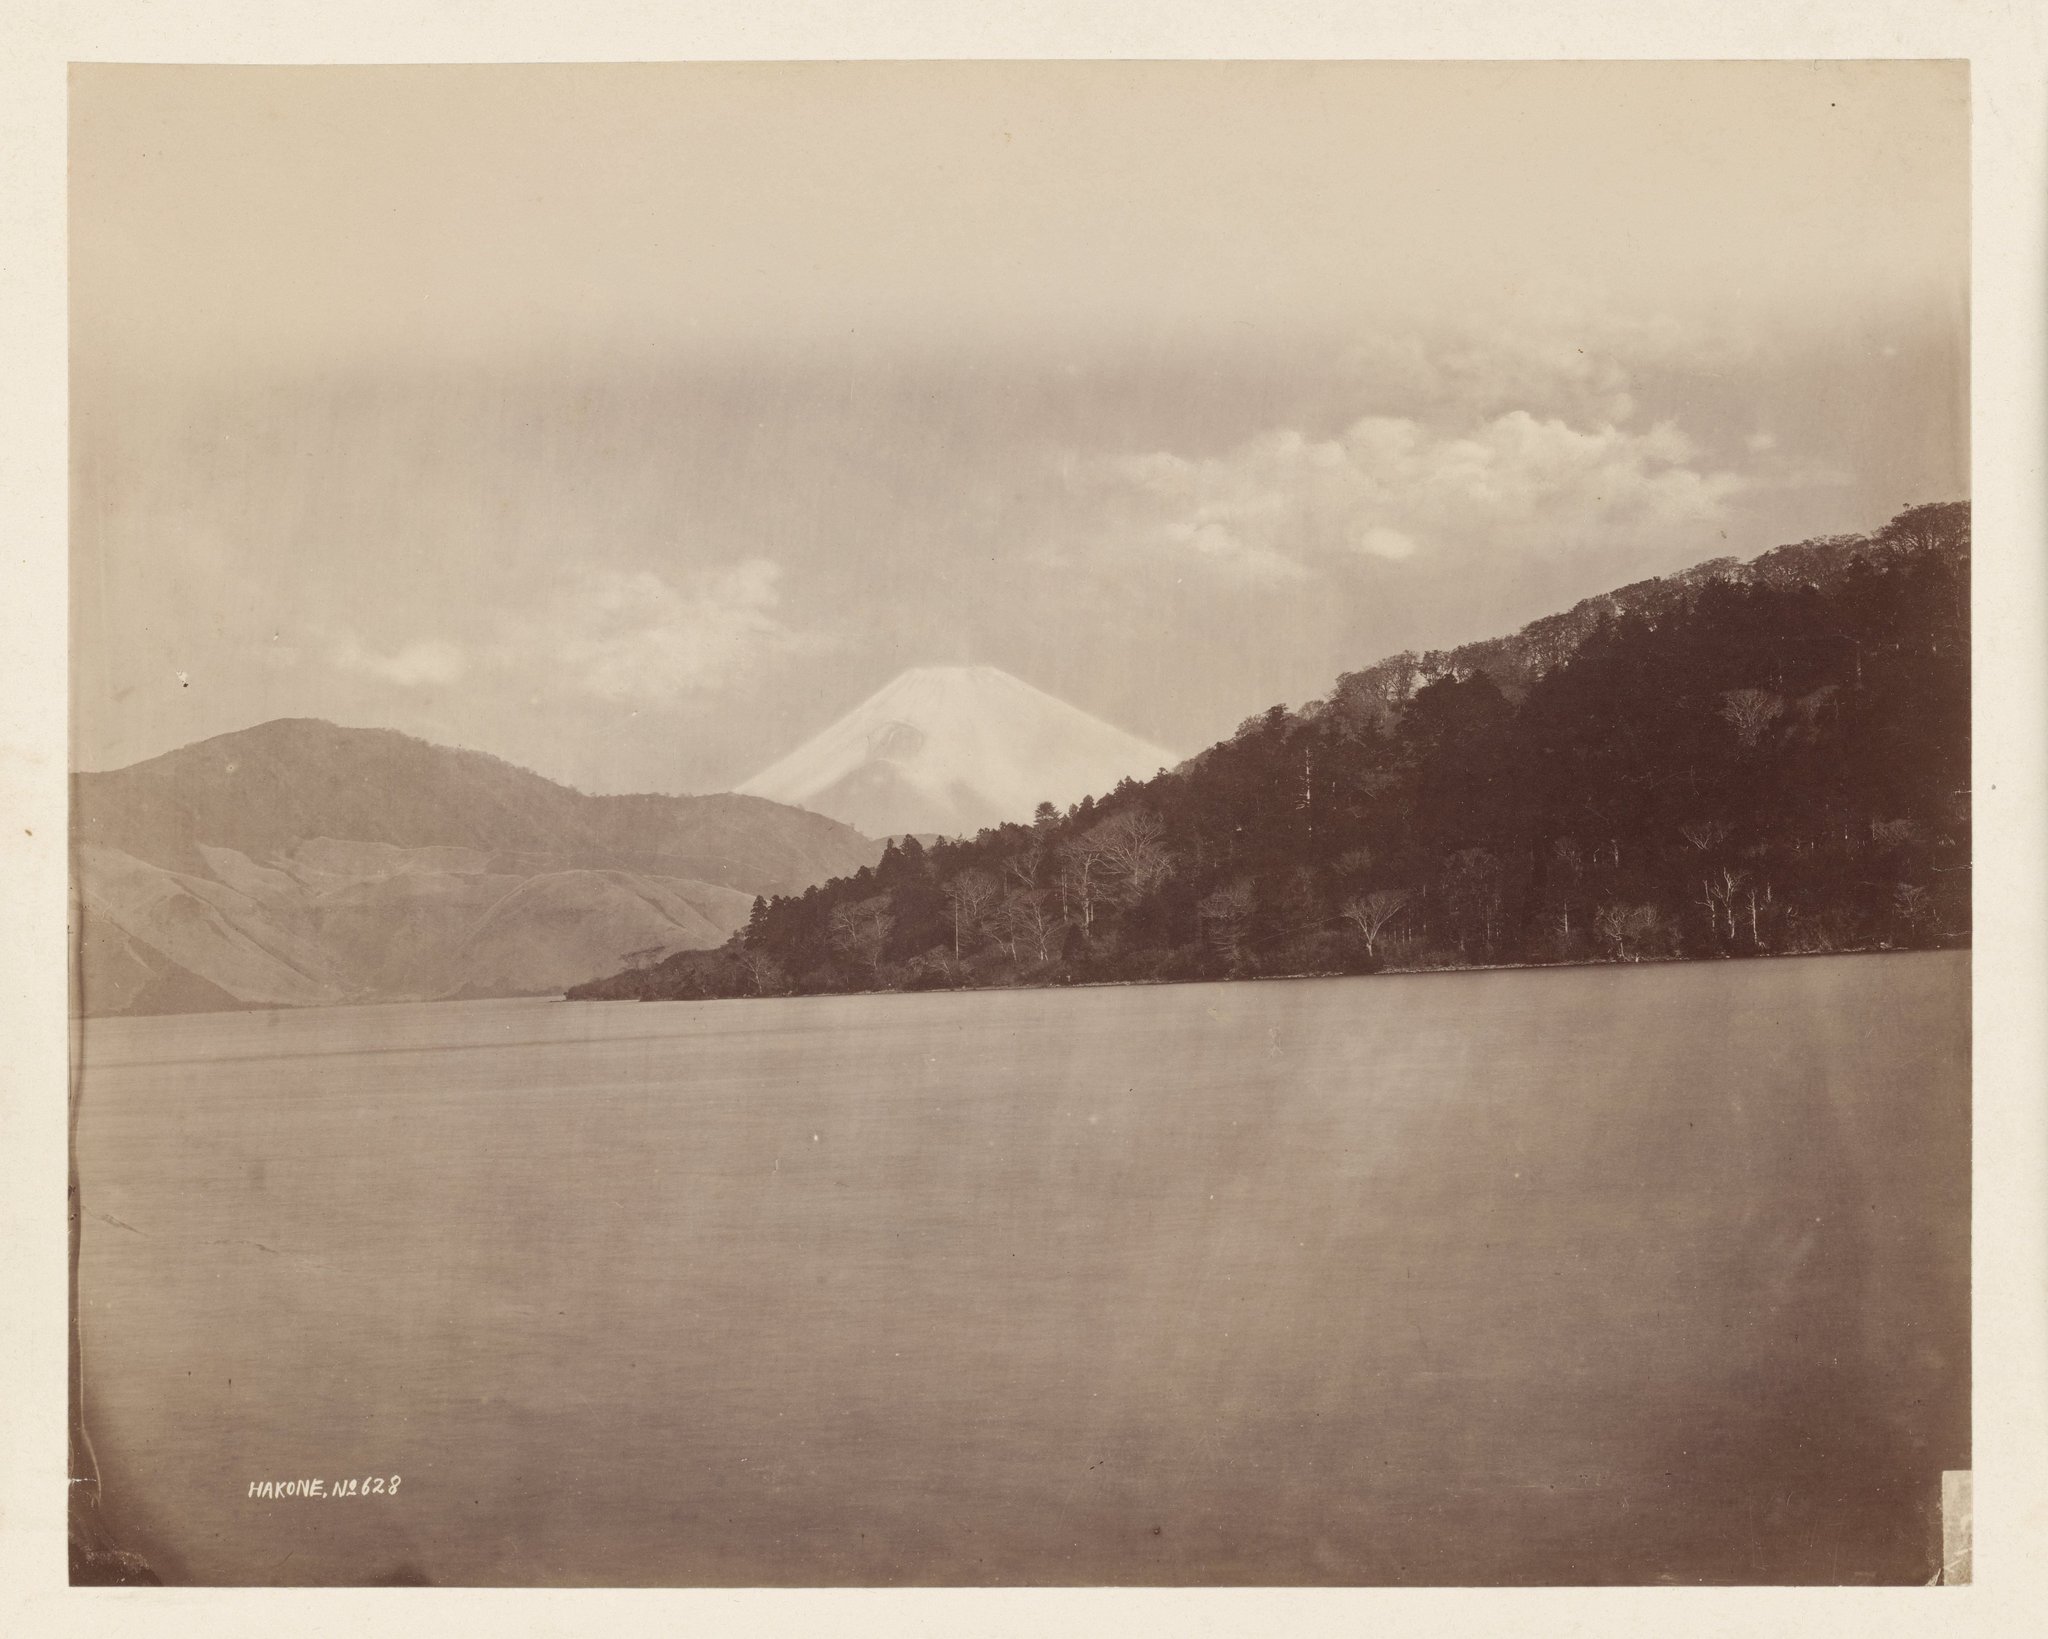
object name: photograph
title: Hakone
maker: Anonymous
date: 1855-1890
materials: cardboard, paper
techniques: albumen print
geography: hakone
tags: lake, volcano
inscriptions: inscription: ‘Hakone met Fudschijama’